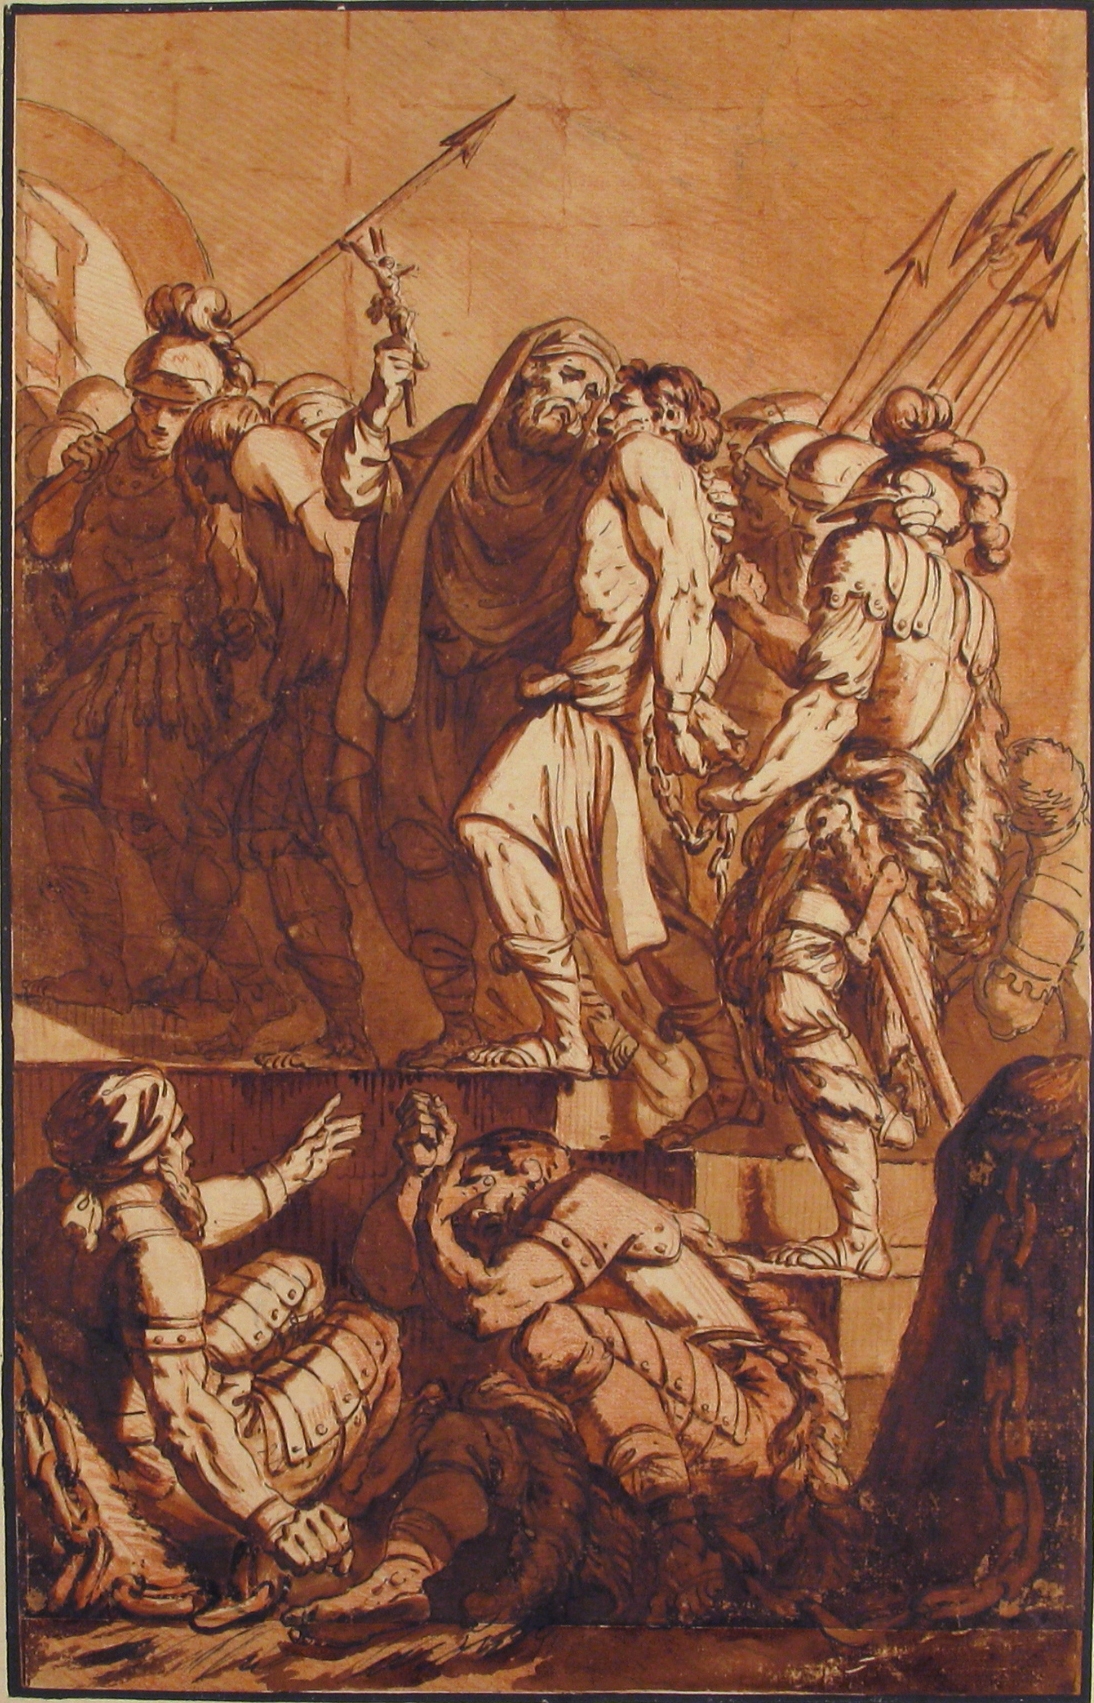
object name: drawing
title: Prisoners Led Out of a Dungeon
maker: philippe louis parizeau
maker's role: artist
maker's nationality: french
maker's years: 1740-1801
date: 1786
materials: chalk, graphite, ink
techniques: printmaking, pen, wash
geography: france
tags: soldiers,prisoners,weapons